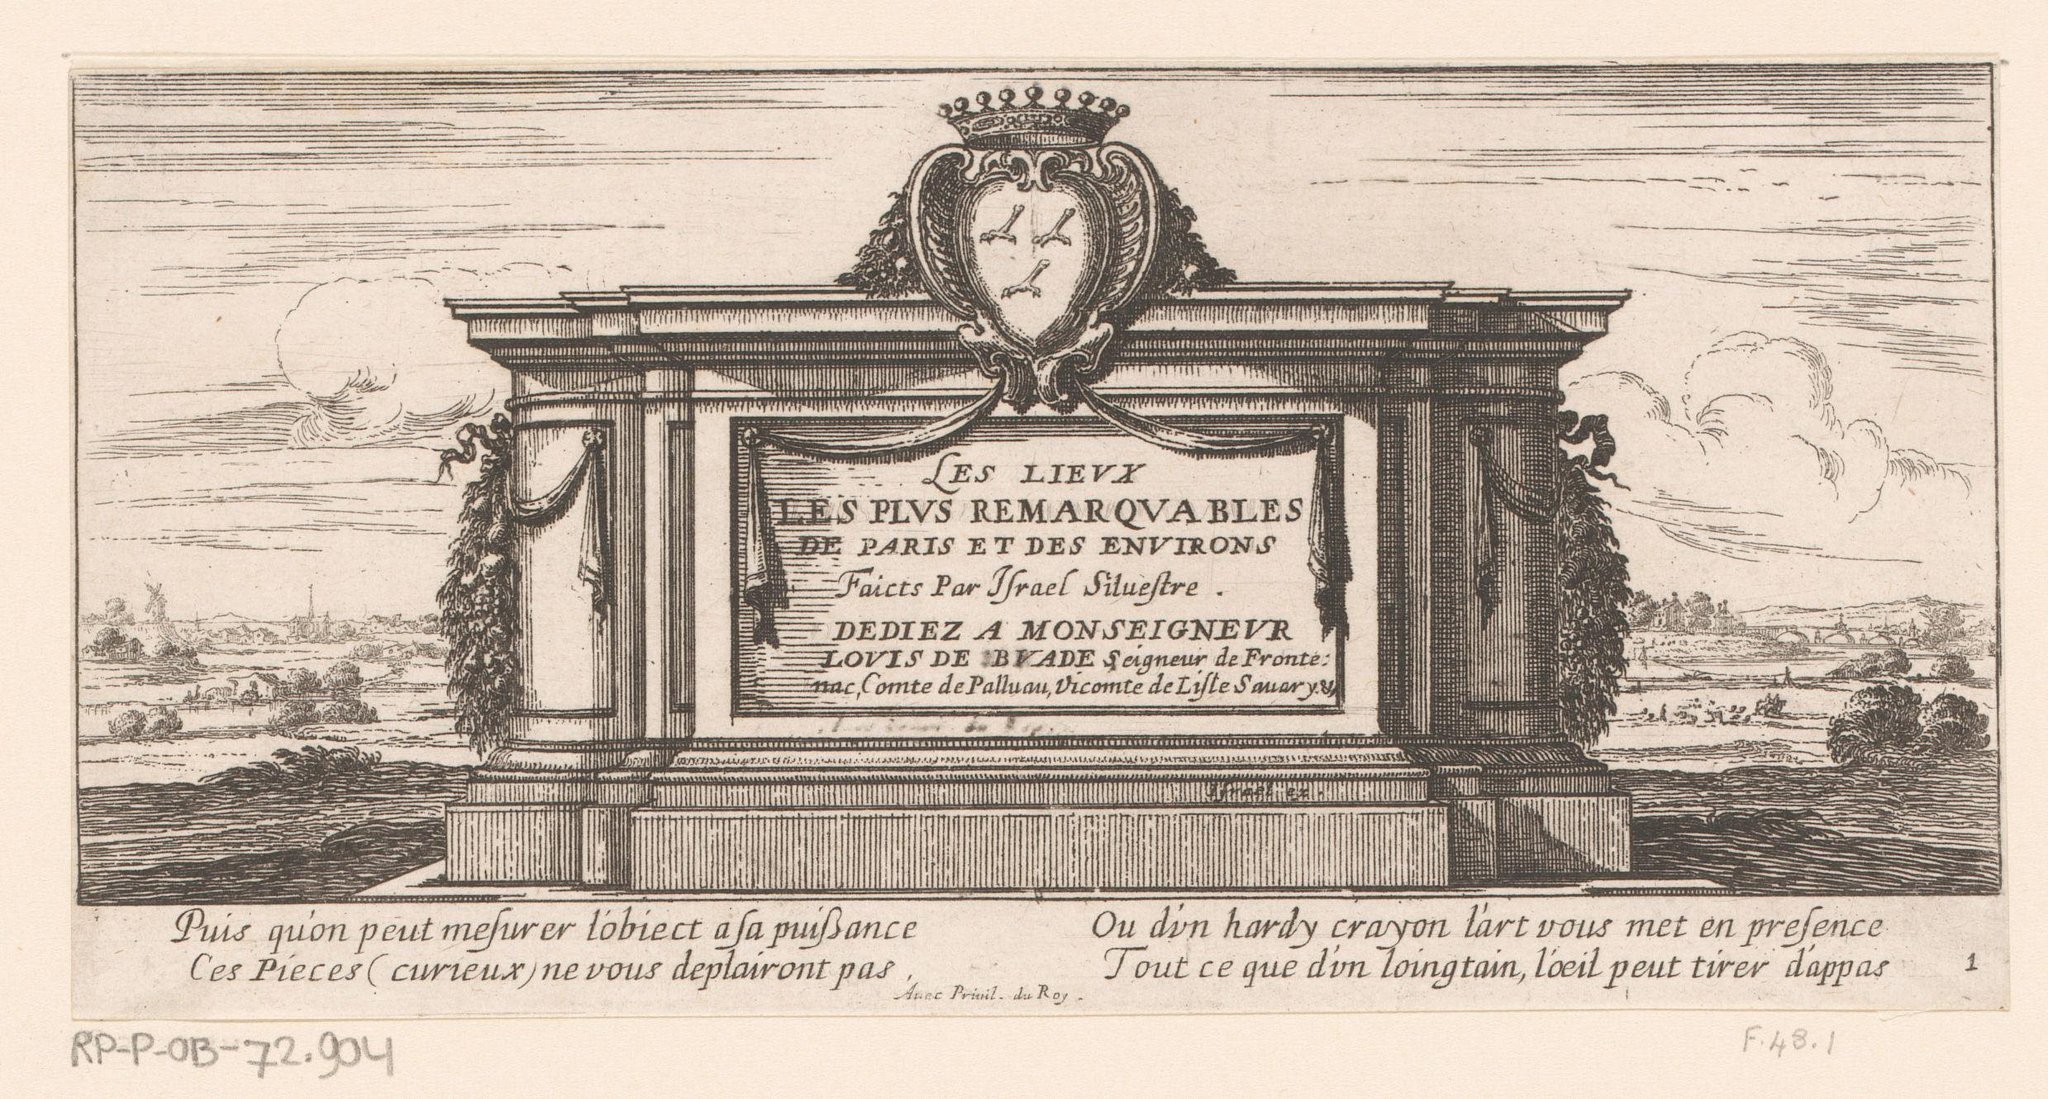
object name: print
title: De meest opmerkelijke plaatsen in Parijs en omgeving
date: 1655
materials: paper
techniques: engraving, etching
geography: france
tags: landscapes, pedestal of a piece of sculpture (perhaps in the form of a herm)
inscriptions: collector's mark: Lugt 240